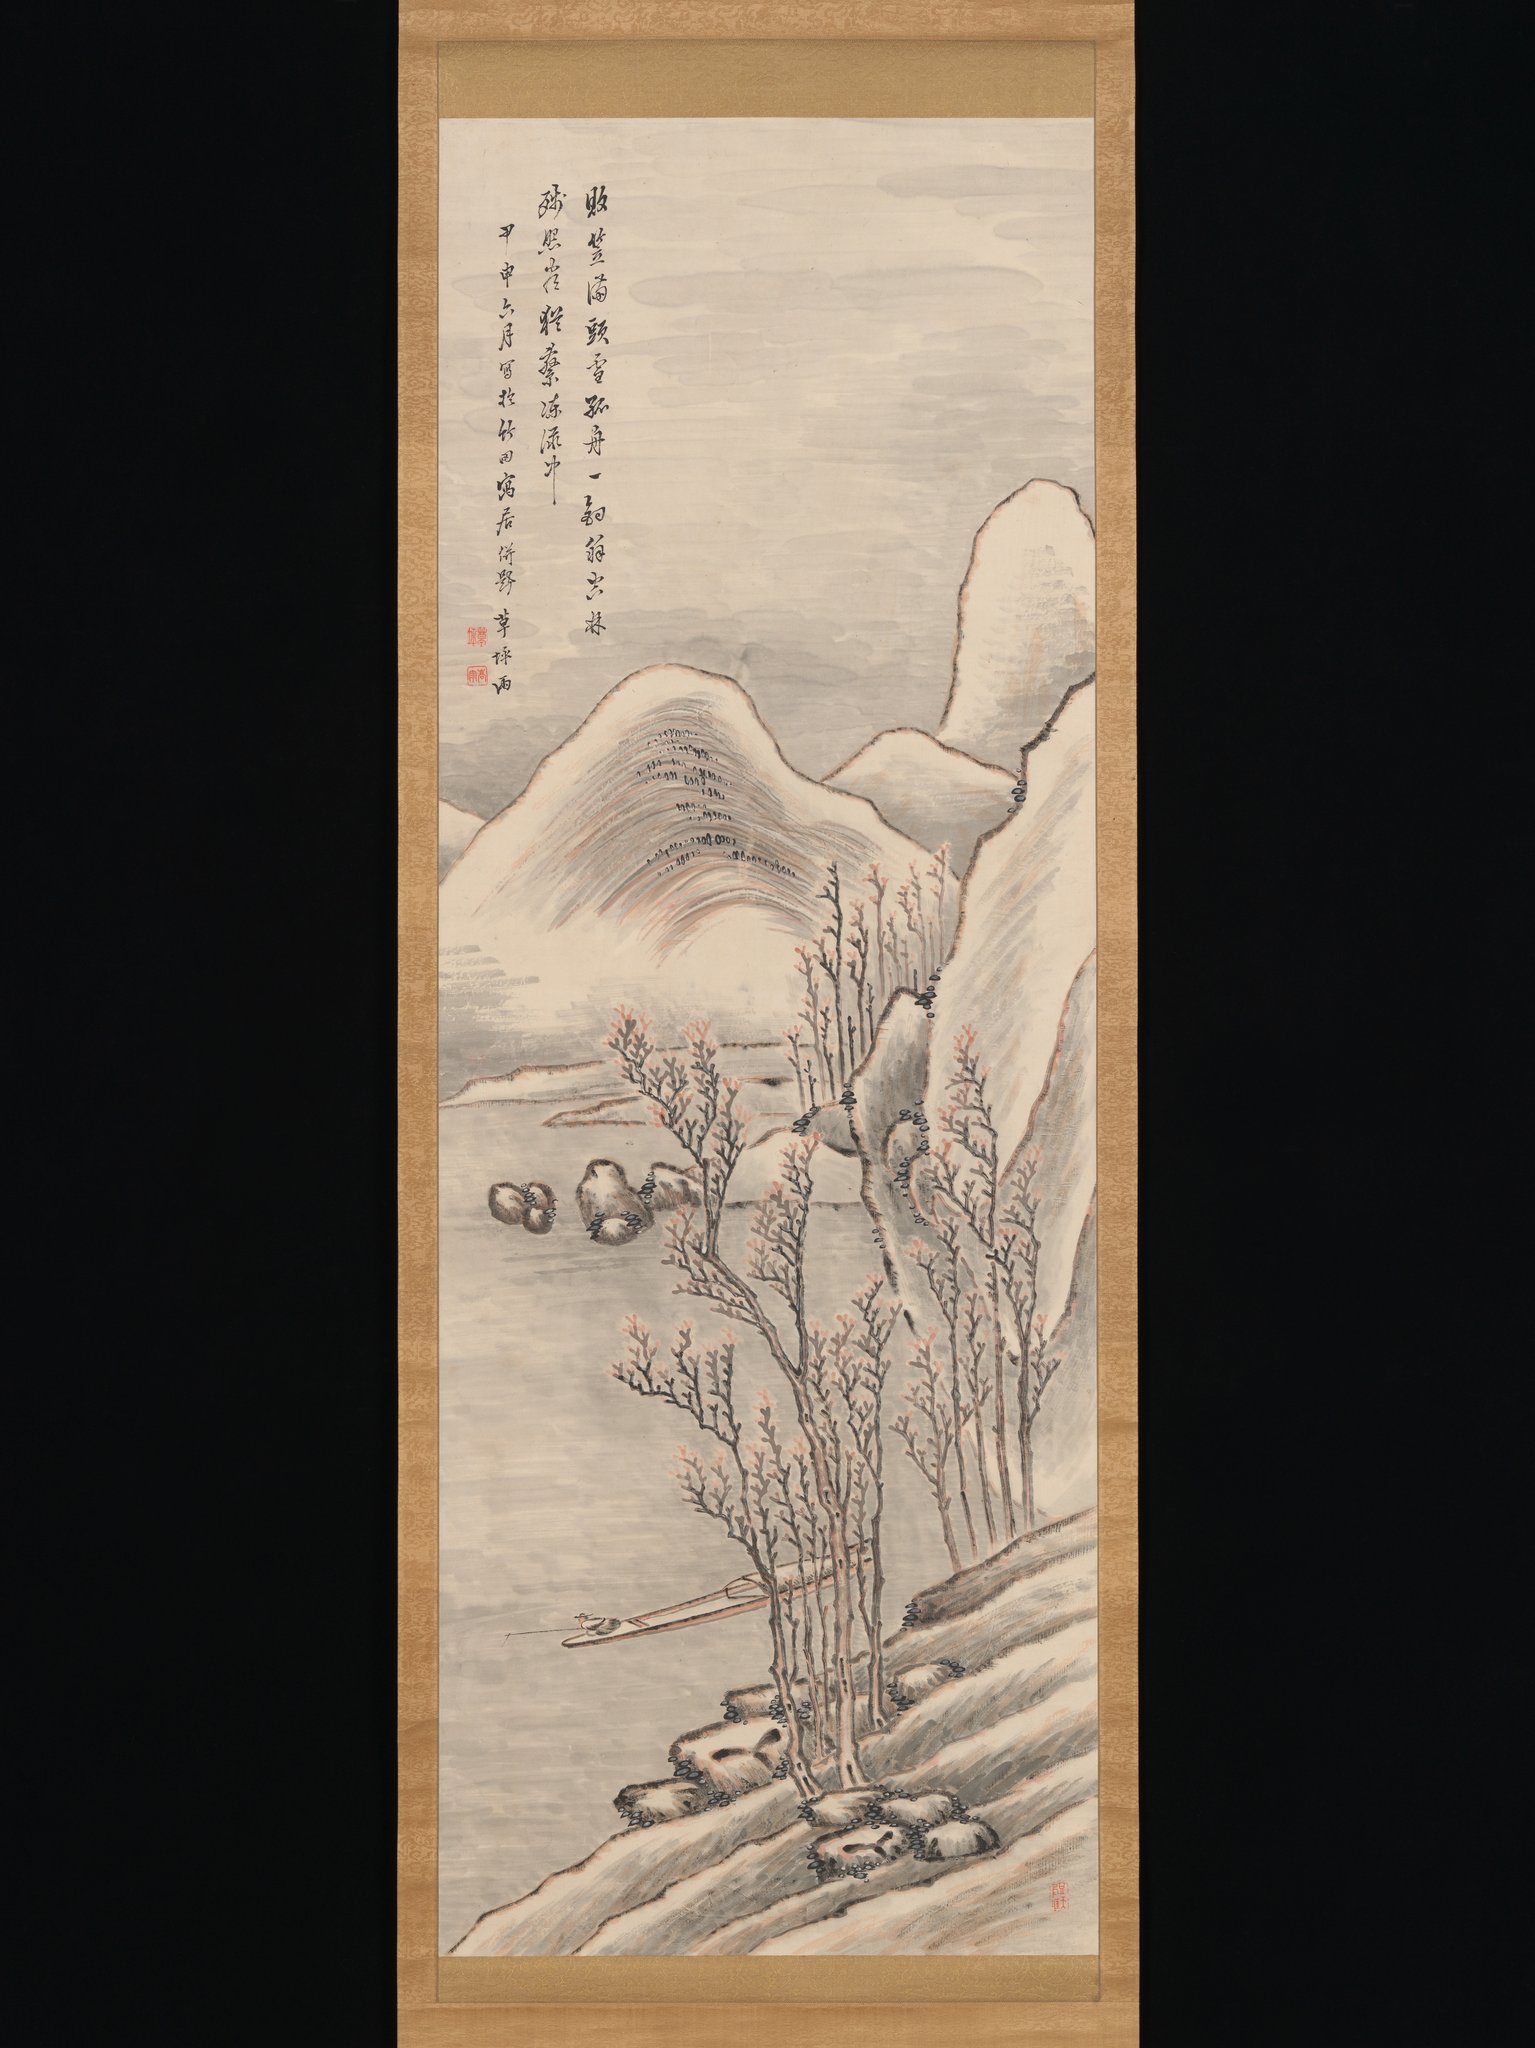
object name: hanging scroll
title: Snowy Landscape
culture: japanese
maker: takahashi sōhei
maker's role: artist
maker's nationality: japanese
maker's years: 1804-1835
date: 1824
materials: ink, paper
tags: landscapes,snow